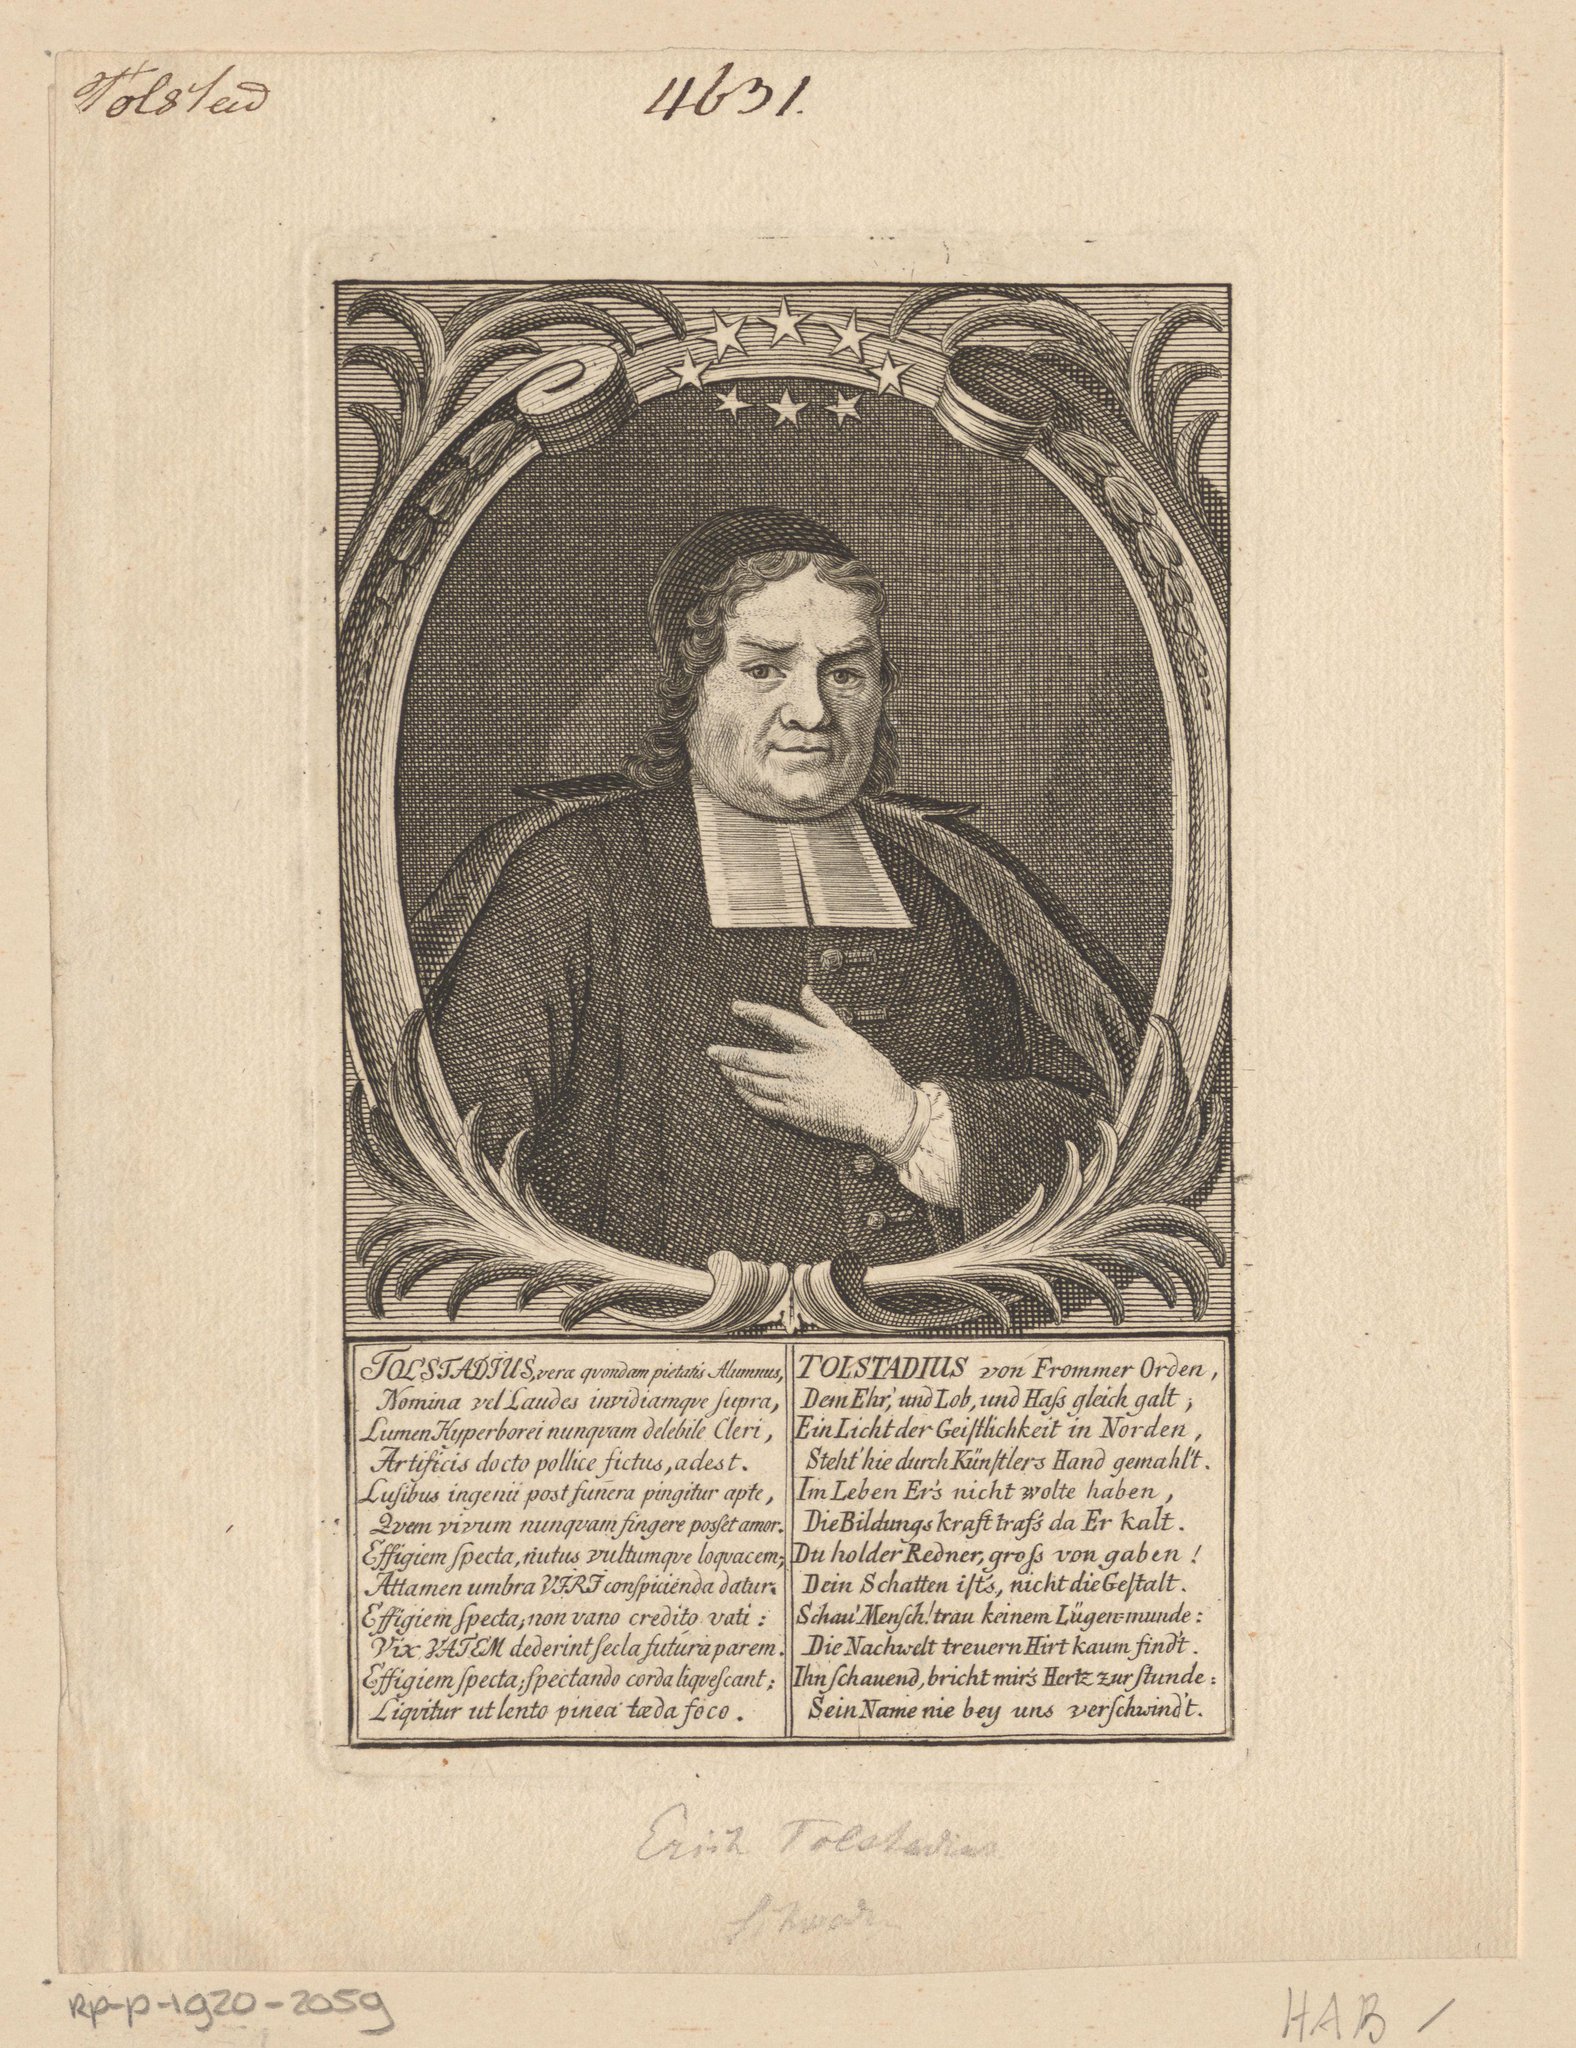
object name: print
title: Portret van Erik Tolstadius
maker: Anonymous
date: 1761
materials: paper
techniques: engraving, etching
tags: theologian, historical persons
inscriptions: collector's mark: Lugt 2228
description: Prent waarschijnlijk uit: Tolstadius, Erik, Nordische Sammlungen, welche Exempel lebendigen und wahren Gottseligkeit im Reiche Schweden in sich halten. Stockholm: Rosten Guter Freunde, 1761, dl. 2.